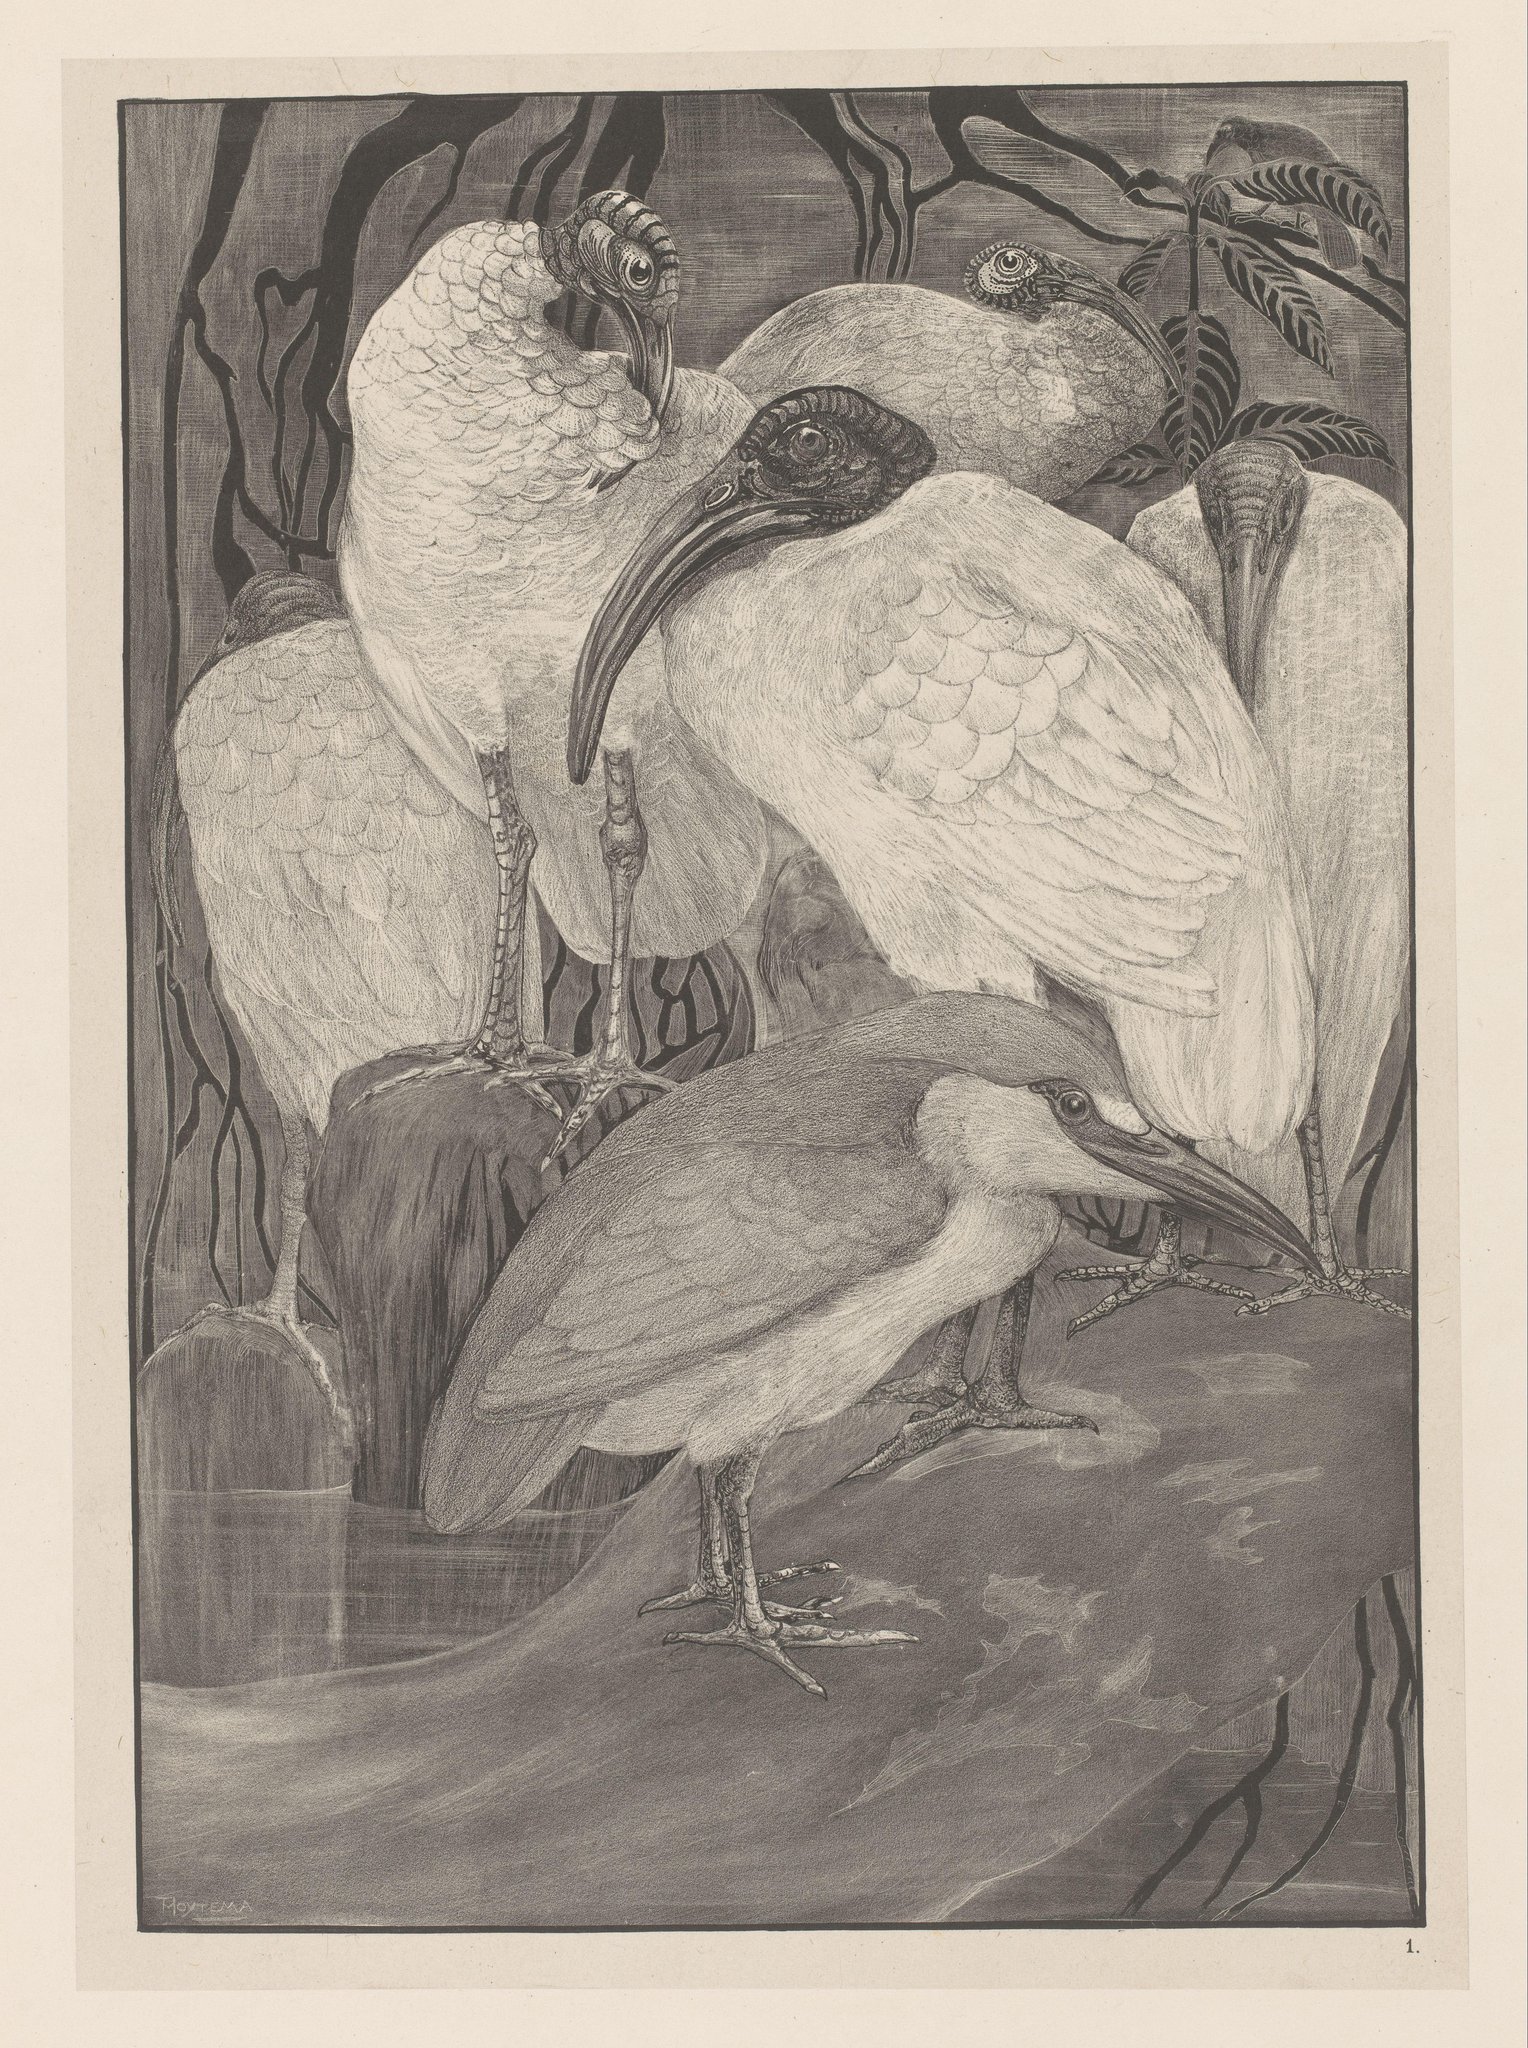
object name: print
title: Dierstudies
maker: theo van hoytema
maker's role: draughtsman, painter, print maker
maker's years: 1863-1917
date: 1898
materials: paper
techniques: lithograph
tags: shore-birds and wading-birds: ibis, shore-birds and wading-birds: heron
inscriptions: number: ‘1.’, collector's mark: Lugt 2233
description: Rechts op de achtergrond een vogel op een tak.